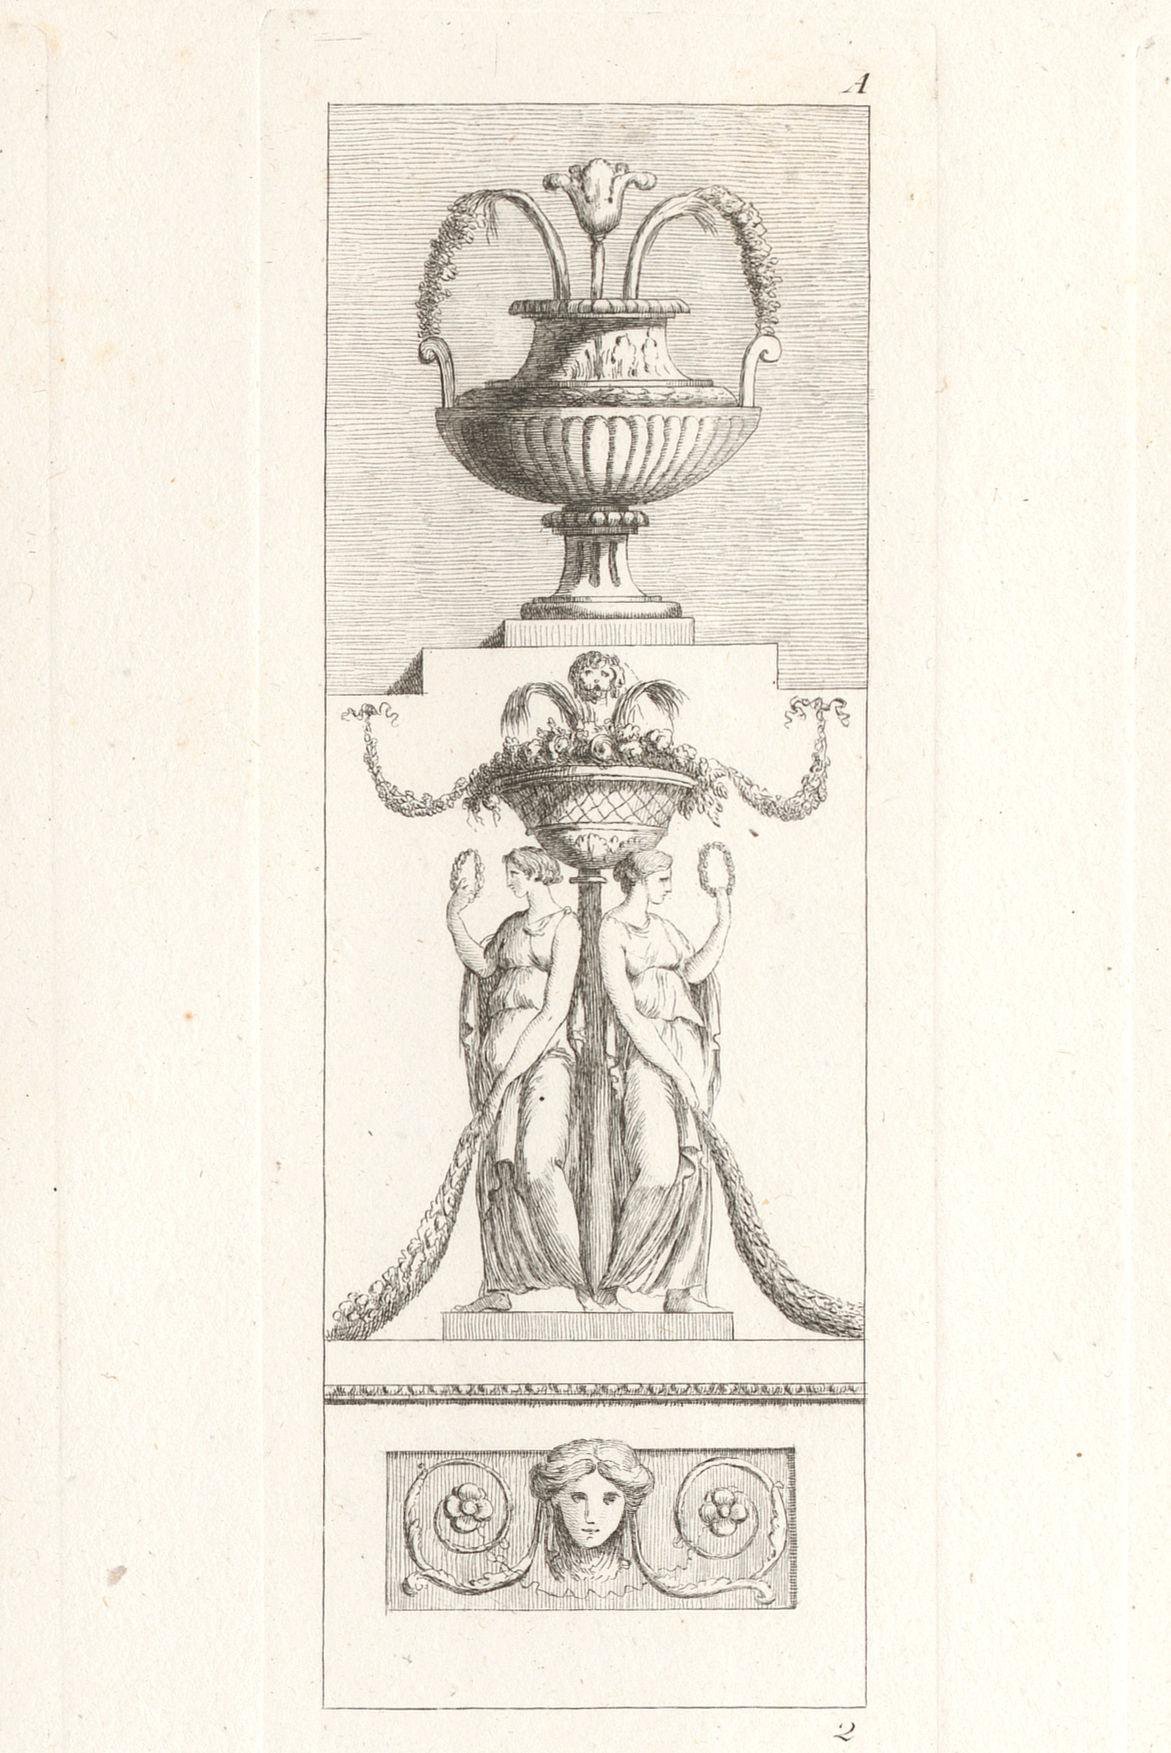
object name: album leaf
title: Arabesken, ontworpen door François Boucher, eerste serie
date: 1802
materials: paper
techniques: etching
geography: paris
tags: ornament ~ arabesque, garland, wreath, vase ~ ornament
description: Doordat dit album bestaat uit meerdere, deels eerder uitgegeven prentreeksen, is de datering niet consequent. Het geheel is op de titelpagina gedateerd op 1802. Deze reeks is niet los gedateerd. De serietitel voor het gehele werk is "Recueil d'arabesques, contenant les loges du Vatican". De andere serietitel is de titel van de specifieke reeks binnen het geheel.